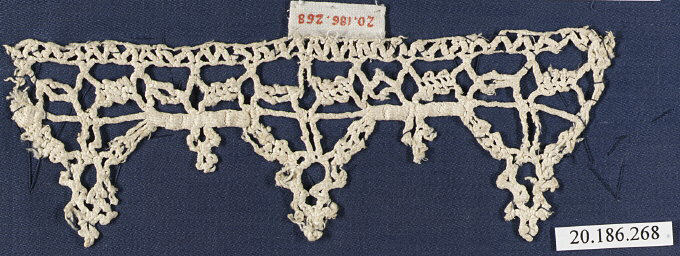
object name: edging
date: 1501-1700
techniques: lace